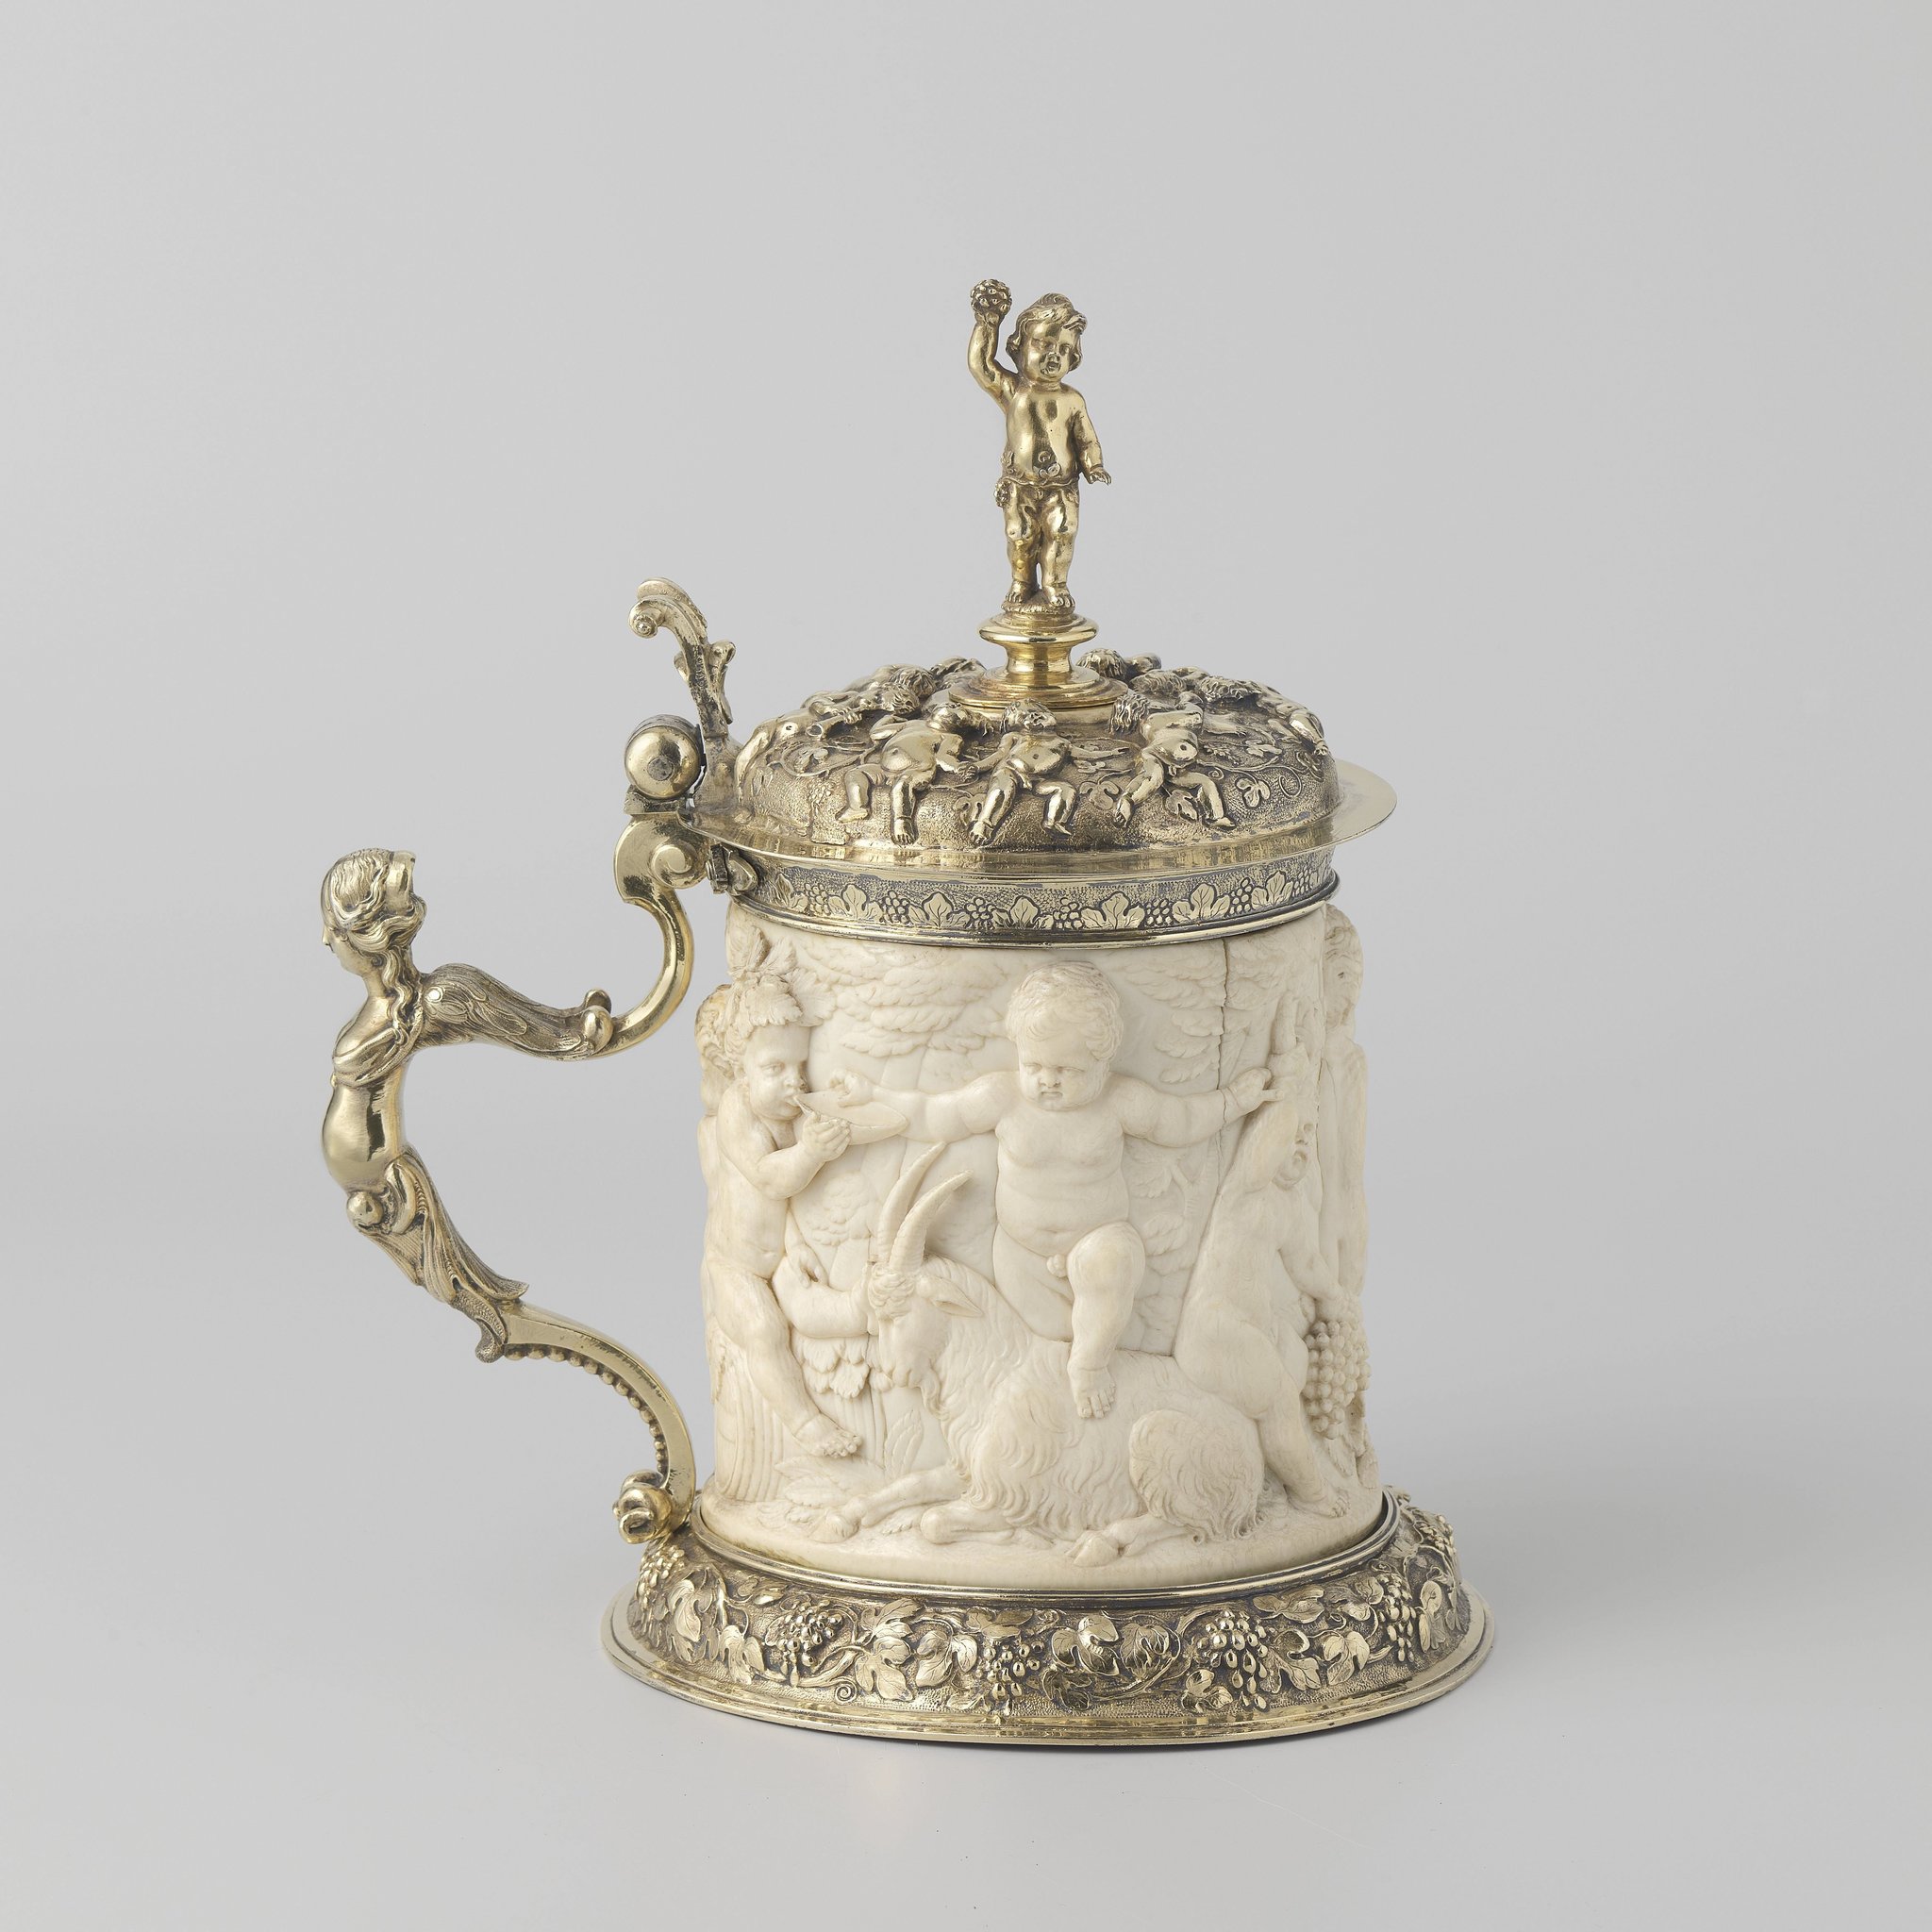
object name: humpen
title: Bacchanal of Putti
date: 1663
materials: gold, ivory, silver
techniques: gilding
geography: öhringen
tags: children's bacchanal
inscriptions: date letter: ‘F’, maker's mark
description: Ivoren pronkbeker, in verguld zilveren montuur. Het ivoor is rondom gesneden met een fries van acht putti, spelend met twee bokken; alle activiteiten en attributen hebben betrekking op wijn: twee wijntonnen, druiventrossen het drinken van wijn uit een fles en een wijnschaaltje. De oorspronkelijke montering zet dit thema door: op het deksel, dat bekroond wordt door een staande putto met een druiventros, is een optocht van dansende en liggende putti tegen wijnranken gedreven. Op de rand van de voet een fries van wijnranken en druiventrossen. Het oor volgt een in deze periode standaardtype, een sierlijke J-vorm opgebouwd uit C-voluten en een vrouwelijke herme.